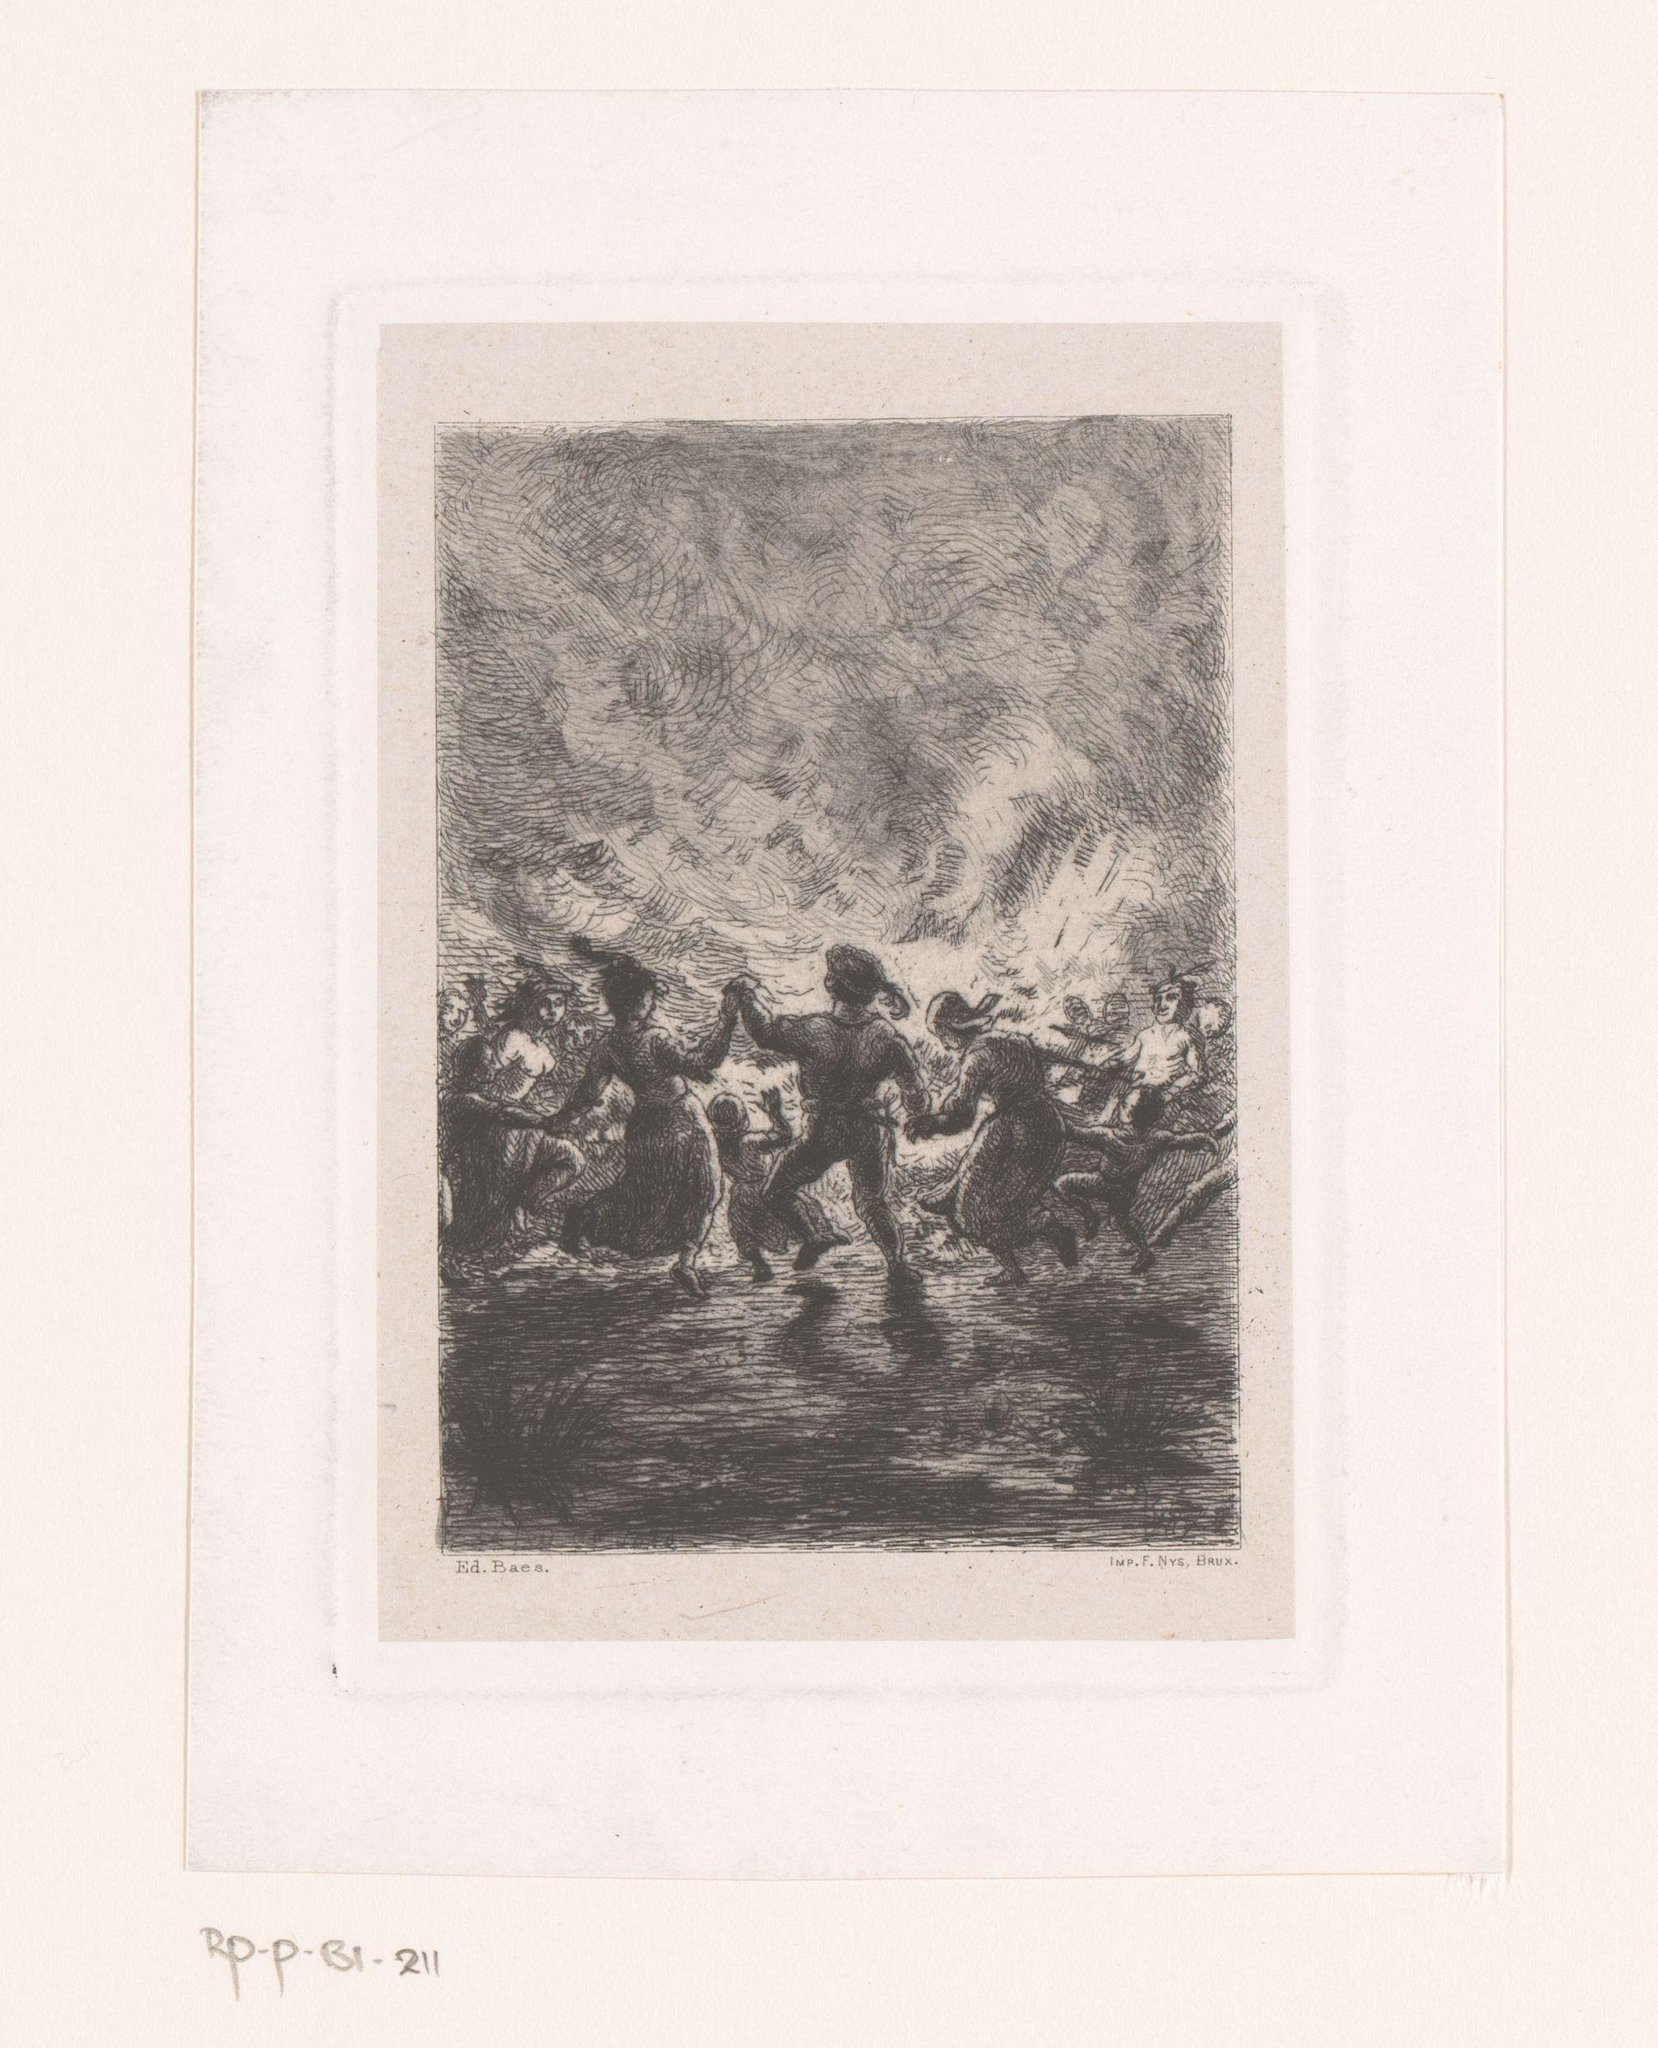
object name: print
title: Rondedans om een vreugdevuur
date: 1875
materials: paper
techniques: drypoint, etching, intaglio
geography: brussels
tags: group dancing around someone or something (folk dancing)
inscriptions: collector's mark: Lugt 2228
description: Prent uit: Album du Journal des Beaux-Arts. Antwerpen: s.n., 1875.